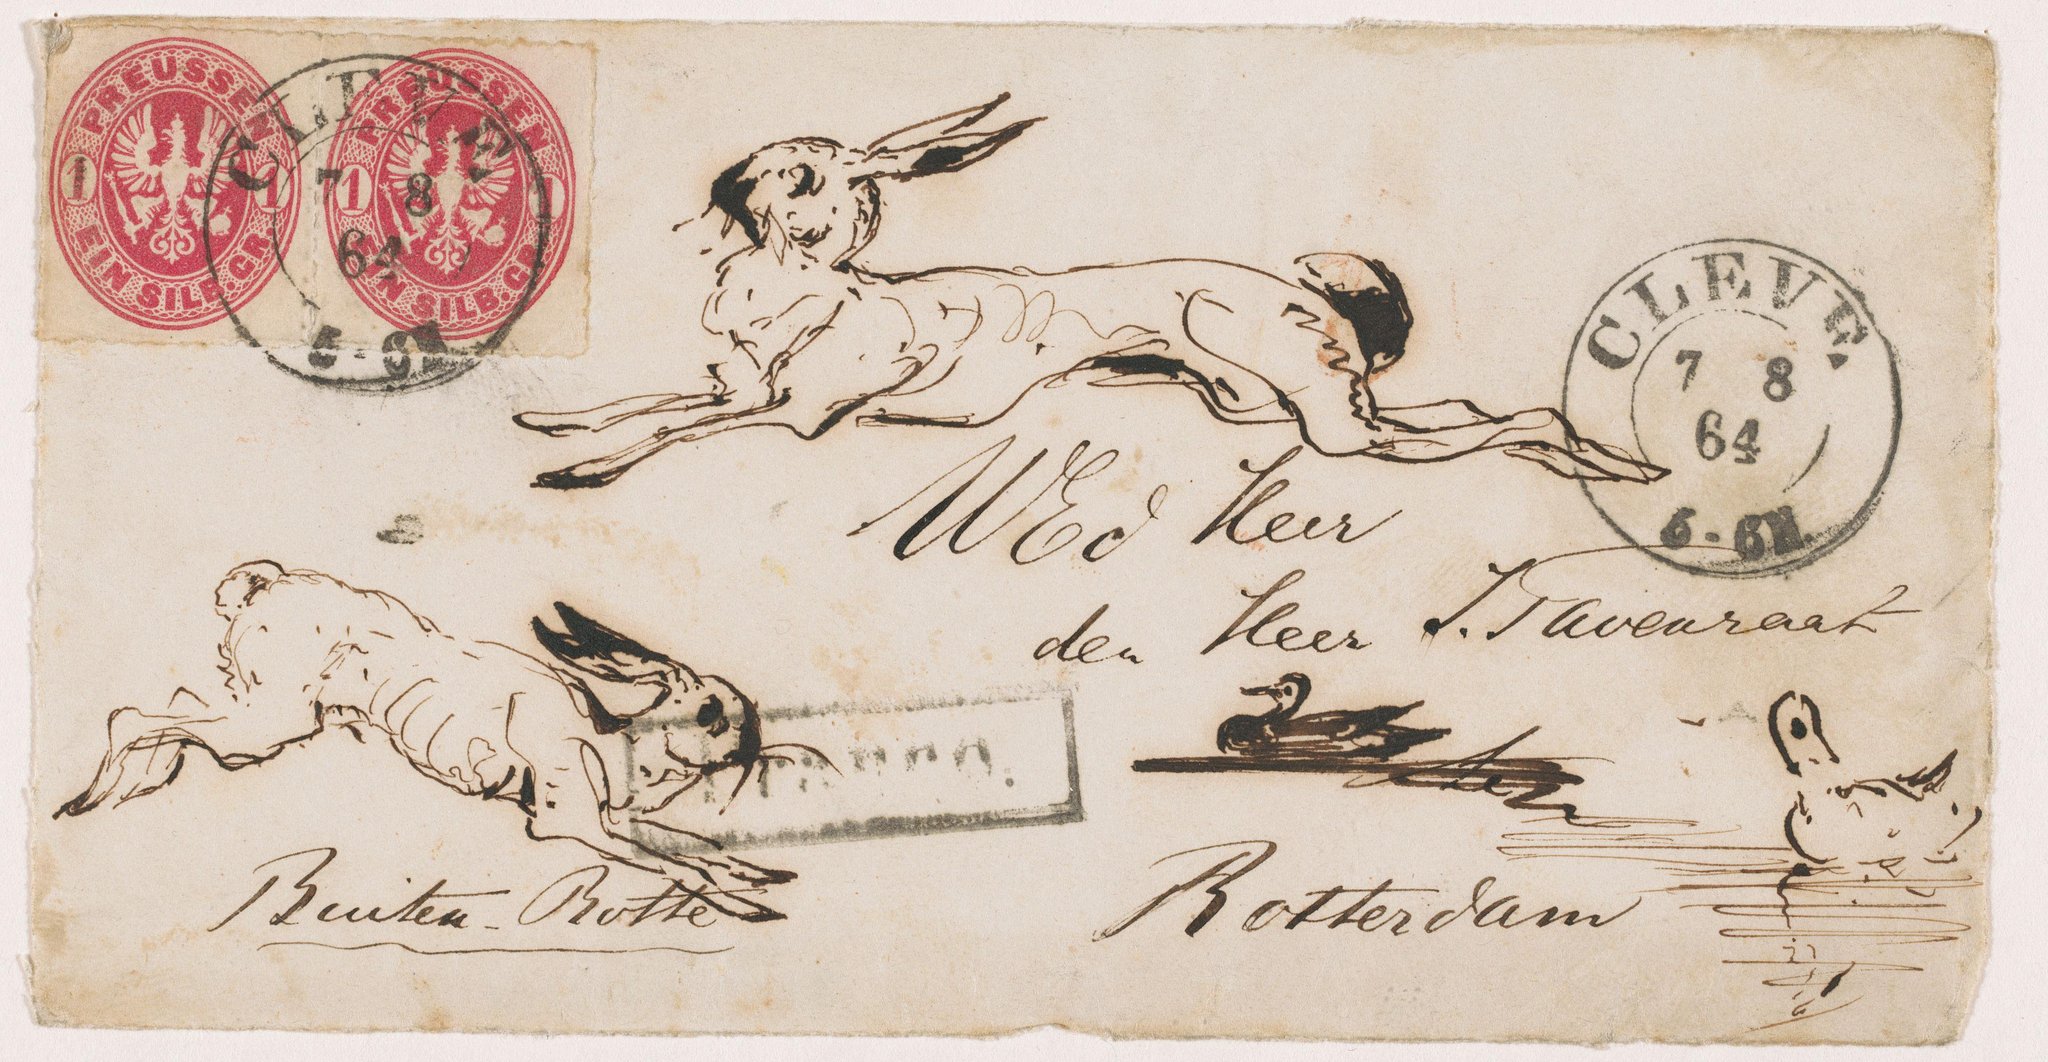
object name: drawing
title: Envelop met hazen en eenden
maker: johannes tavenraat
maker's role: draughtsman, painter, print maker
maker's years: 1809-1881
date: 1864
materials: ink, paper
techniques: pen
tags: rodents: hare, water-birds: duck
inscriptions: signature: ‘Tavenraat’, collector's mark: Lugt 2228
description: Hazen en eenden, getekend op een deel van een envelop met postzegels, gericht aan J. Tavenraat, met poststempel Cleve 7 8 64.